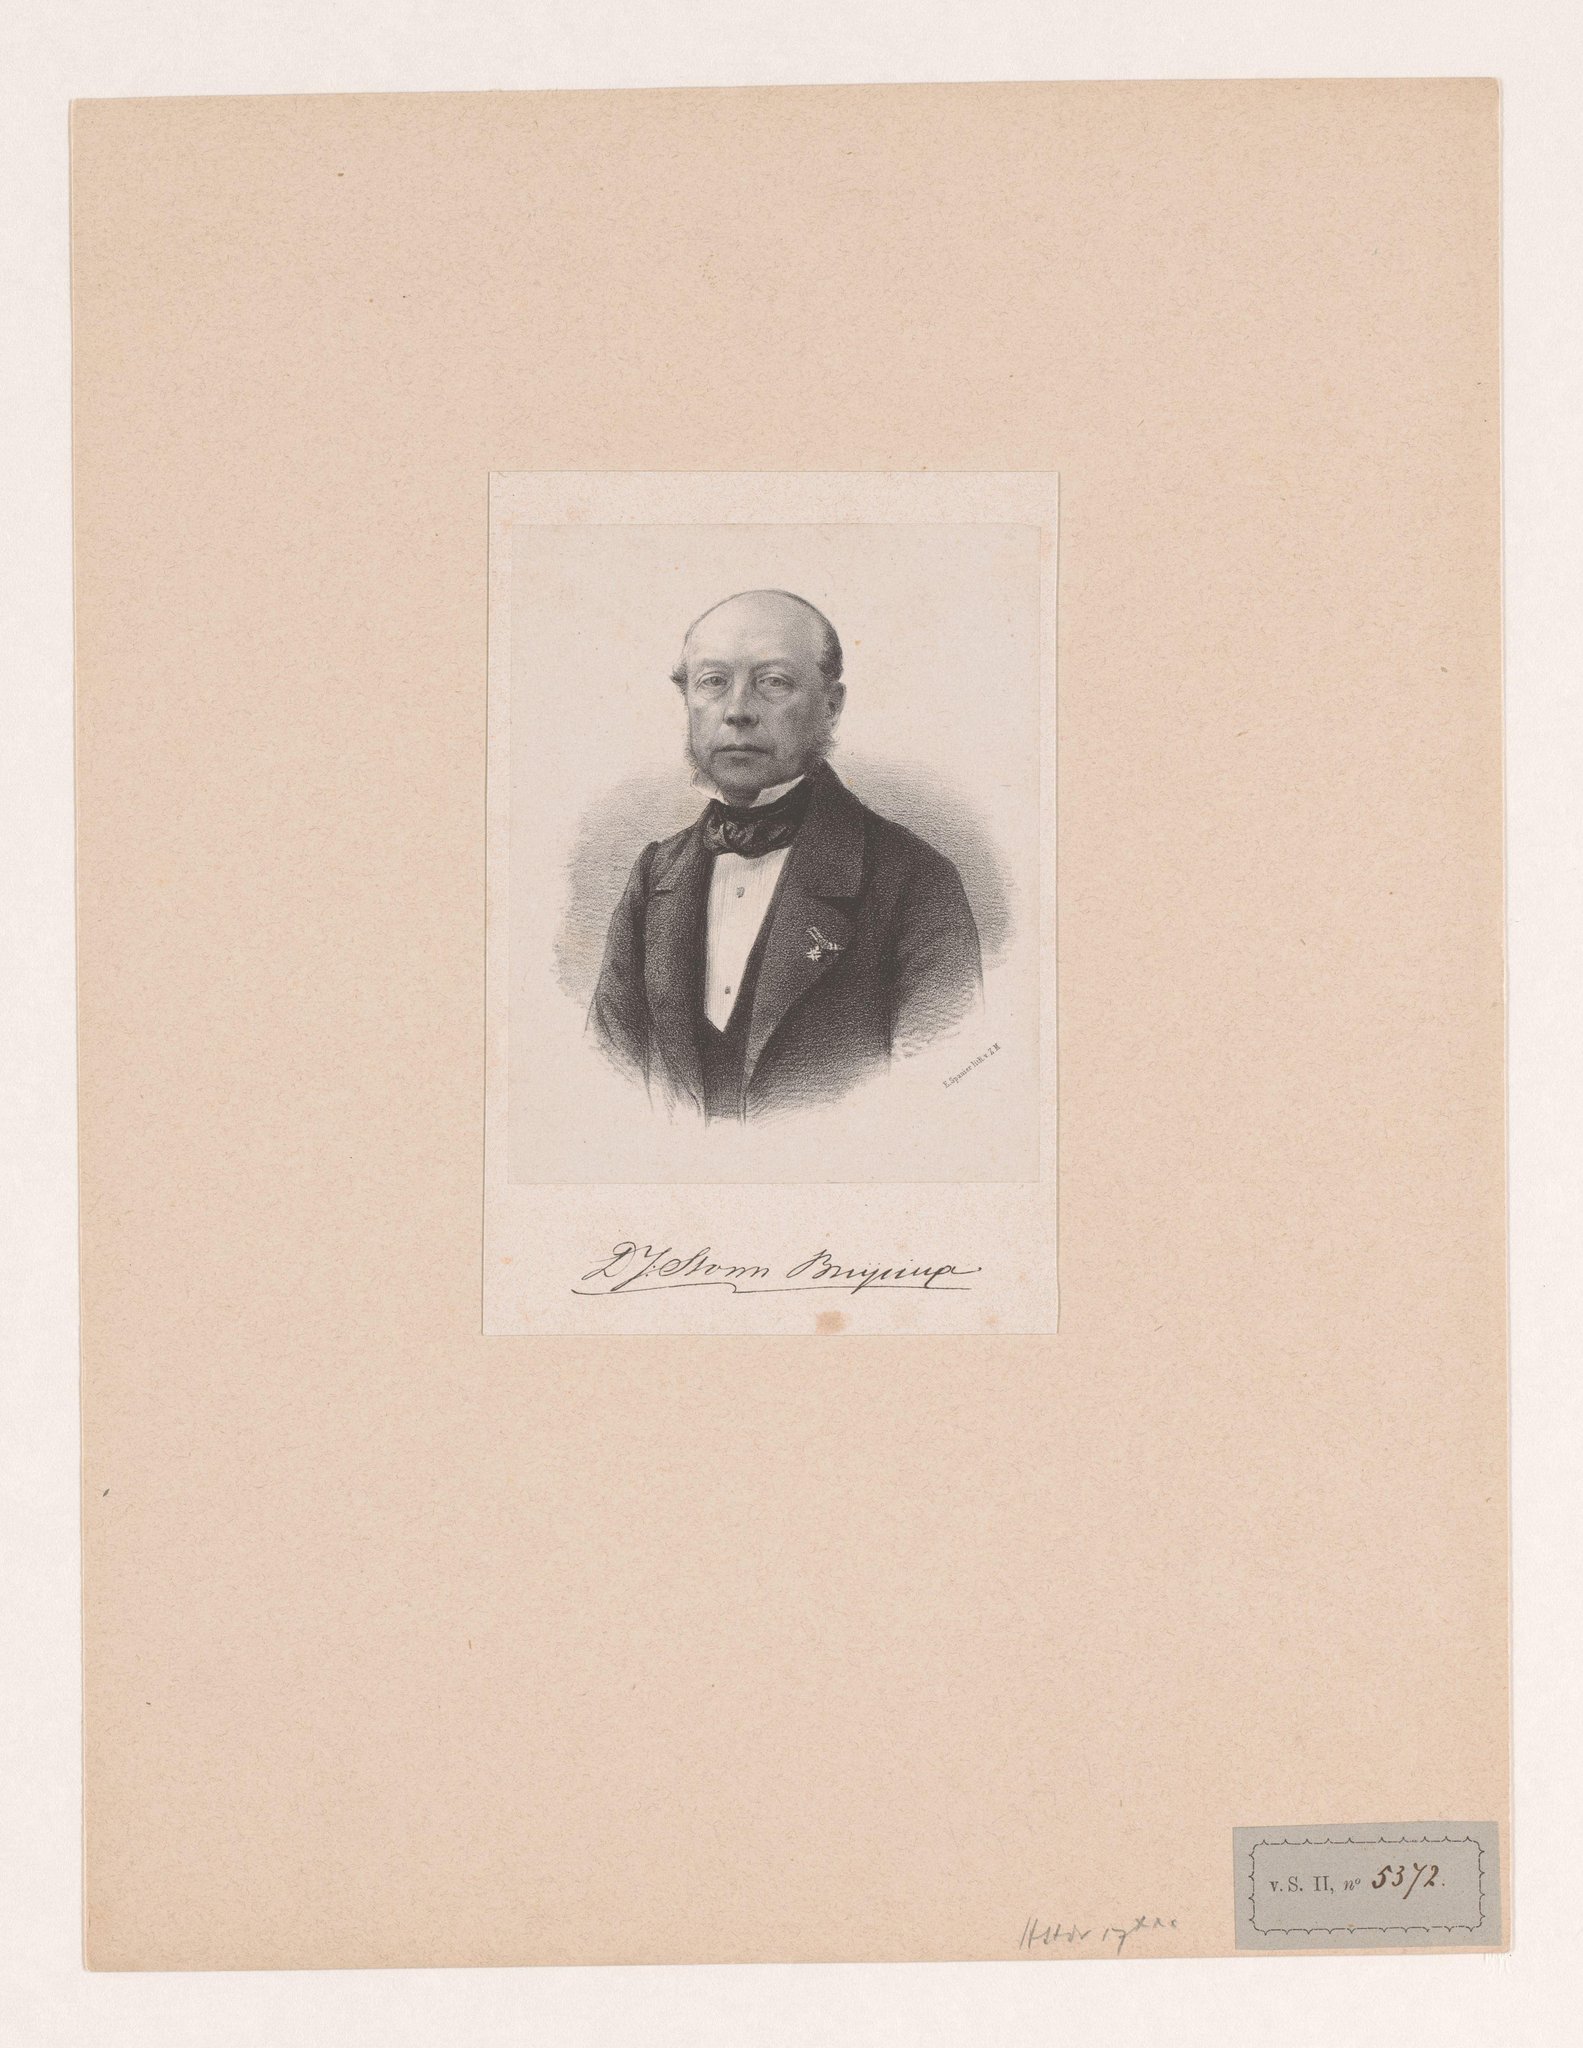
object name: print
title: Portret van Duco Johannes Storm Buysing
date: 1831-1863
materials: paper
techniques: lithograph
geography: the hague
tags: the hague, engineer, historical persons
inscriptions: collector's mark: Lugt 2228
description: Onder het portret de signatuur van de geportretteerde.